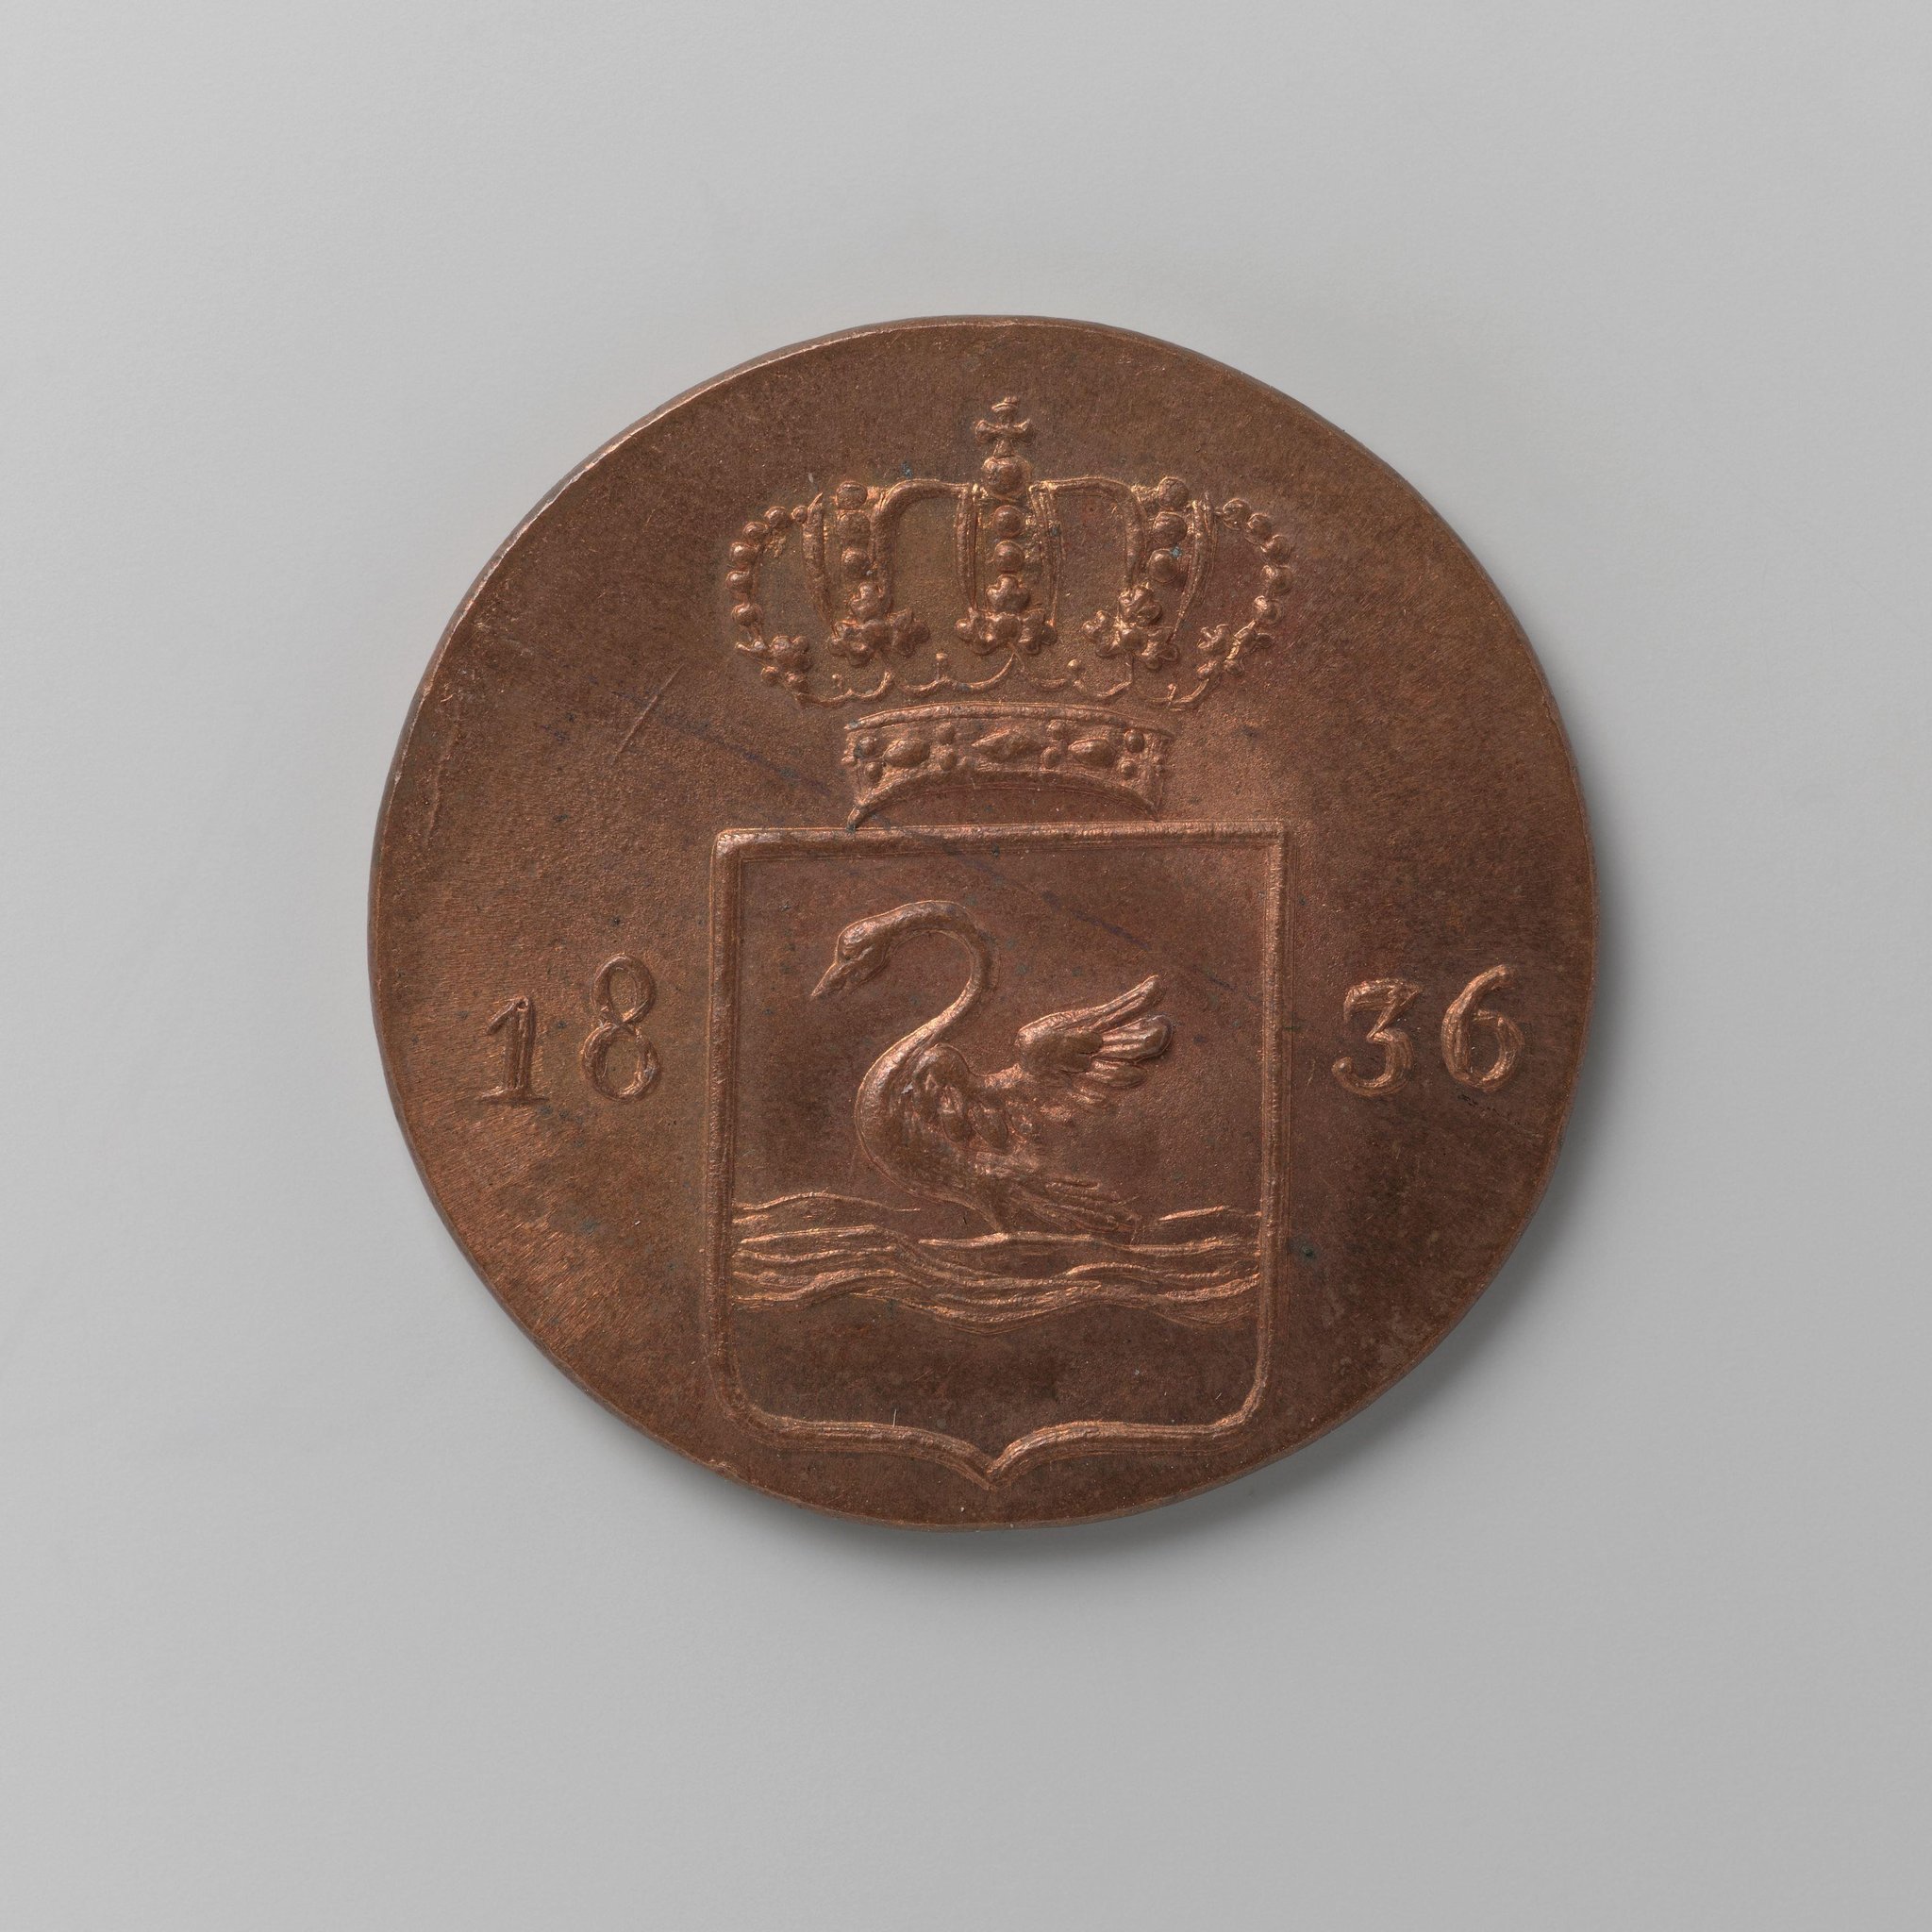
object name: coin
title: Zwaantjesduit voor Nederlands Indië,1836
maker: Anonymous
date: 1836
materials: copper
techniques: striking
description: Koperen proefmunt. Voorzijde: tussen jaartal gekroond wapenschild, waarin zwaan. Keerzijde: tweeregelig opschrift: INDIE NEDERL, waarboven een ster en waaronder twee sterren. Gladde rand.